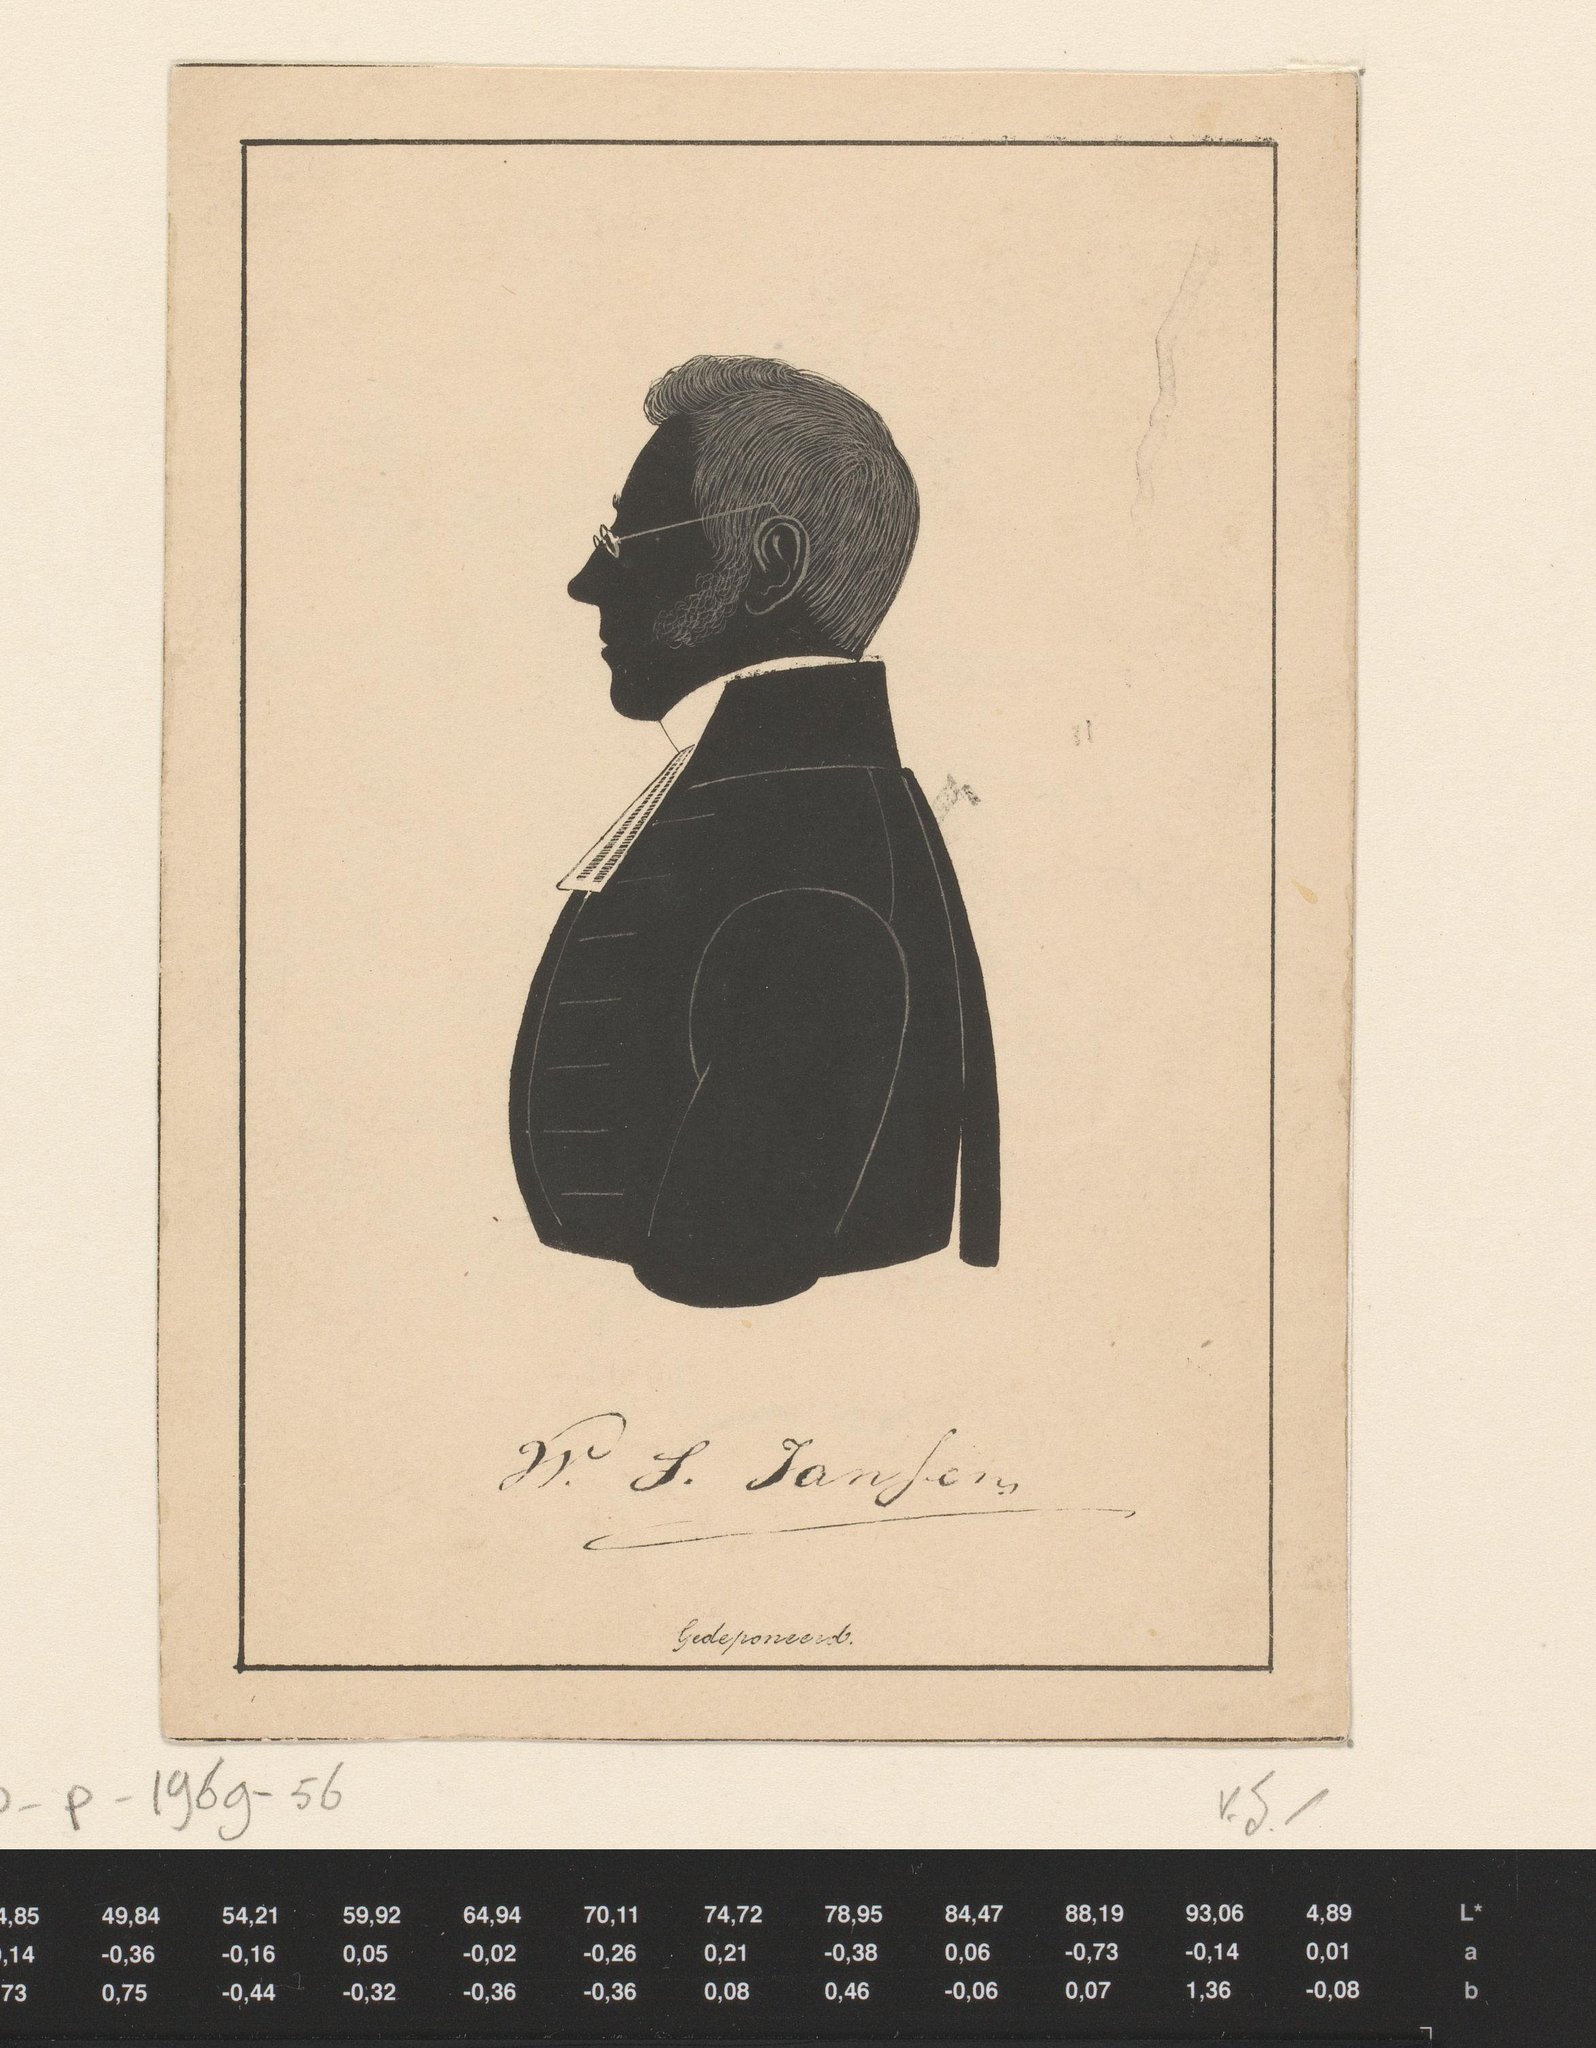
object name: print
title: Silhouetportret van Willem Stroes Jansen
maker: weduwe pieter barbiers (iv)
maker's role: publisher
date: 1818-1862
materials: paper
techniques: hand coloring, lithograph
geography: zwolle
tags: historical persons, functionaries and dignitaries ~ protestant churches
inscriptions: : ‘Gedeponeerd.’, collector's mark: Lugt 2228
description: Met facsimile handtekening van de geportretteerde.